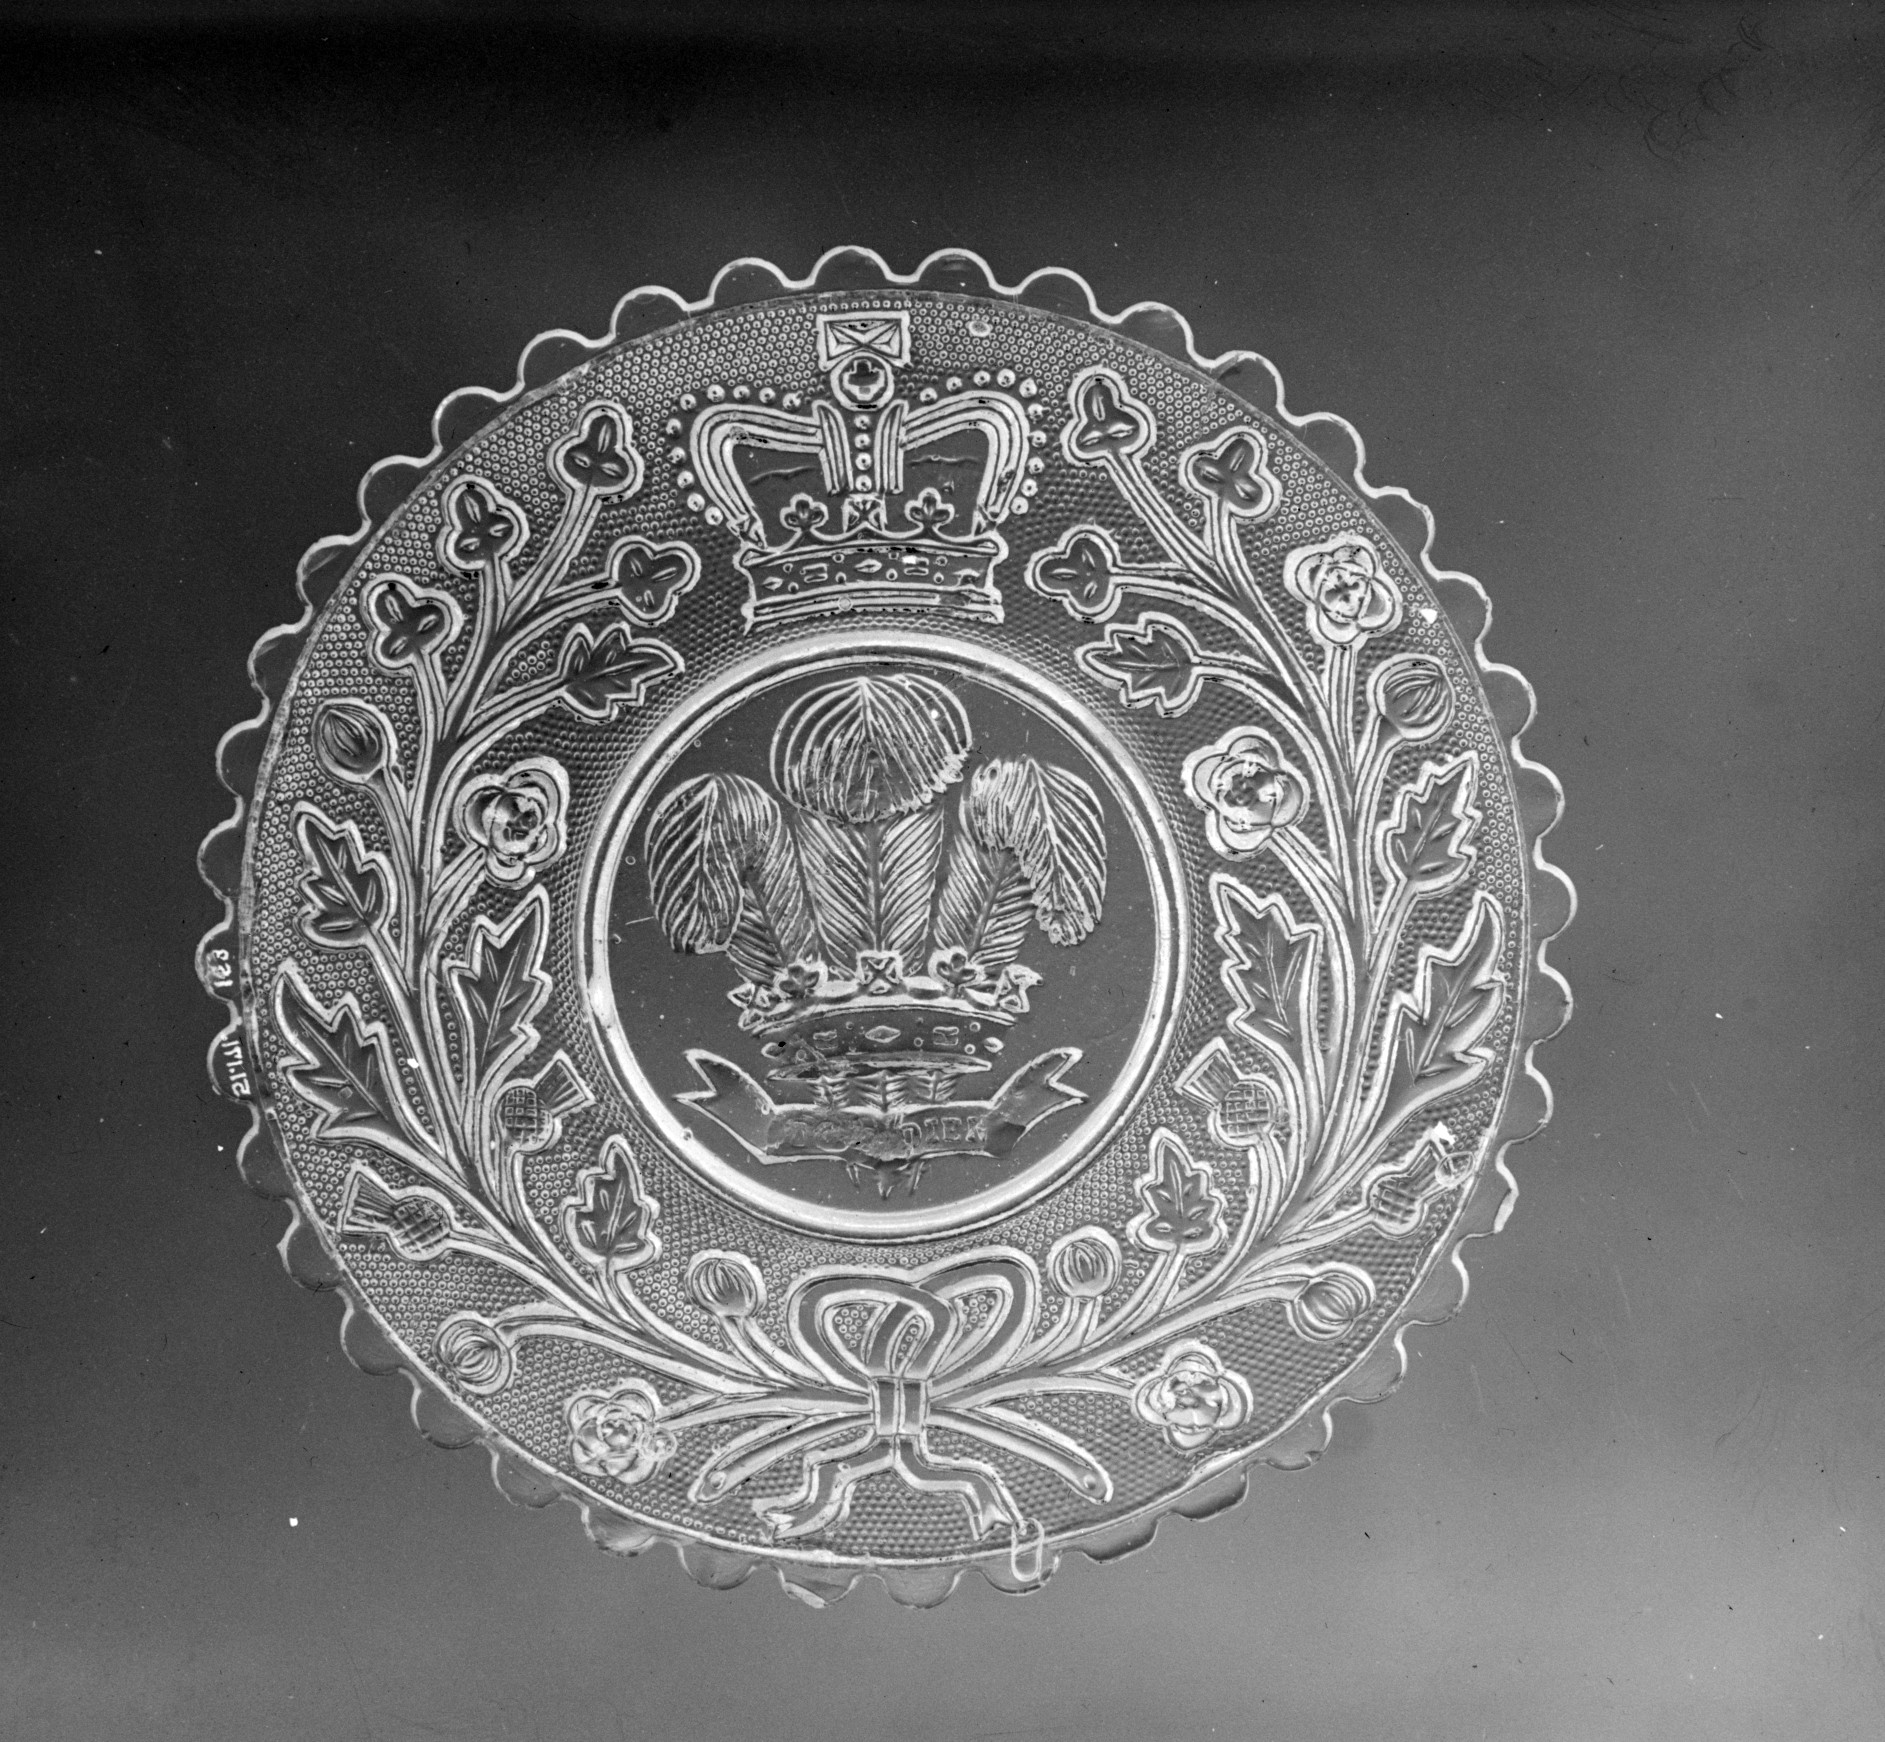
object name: plate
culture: american or british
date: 1842-1845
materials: glass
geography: england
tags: flowers,crowns